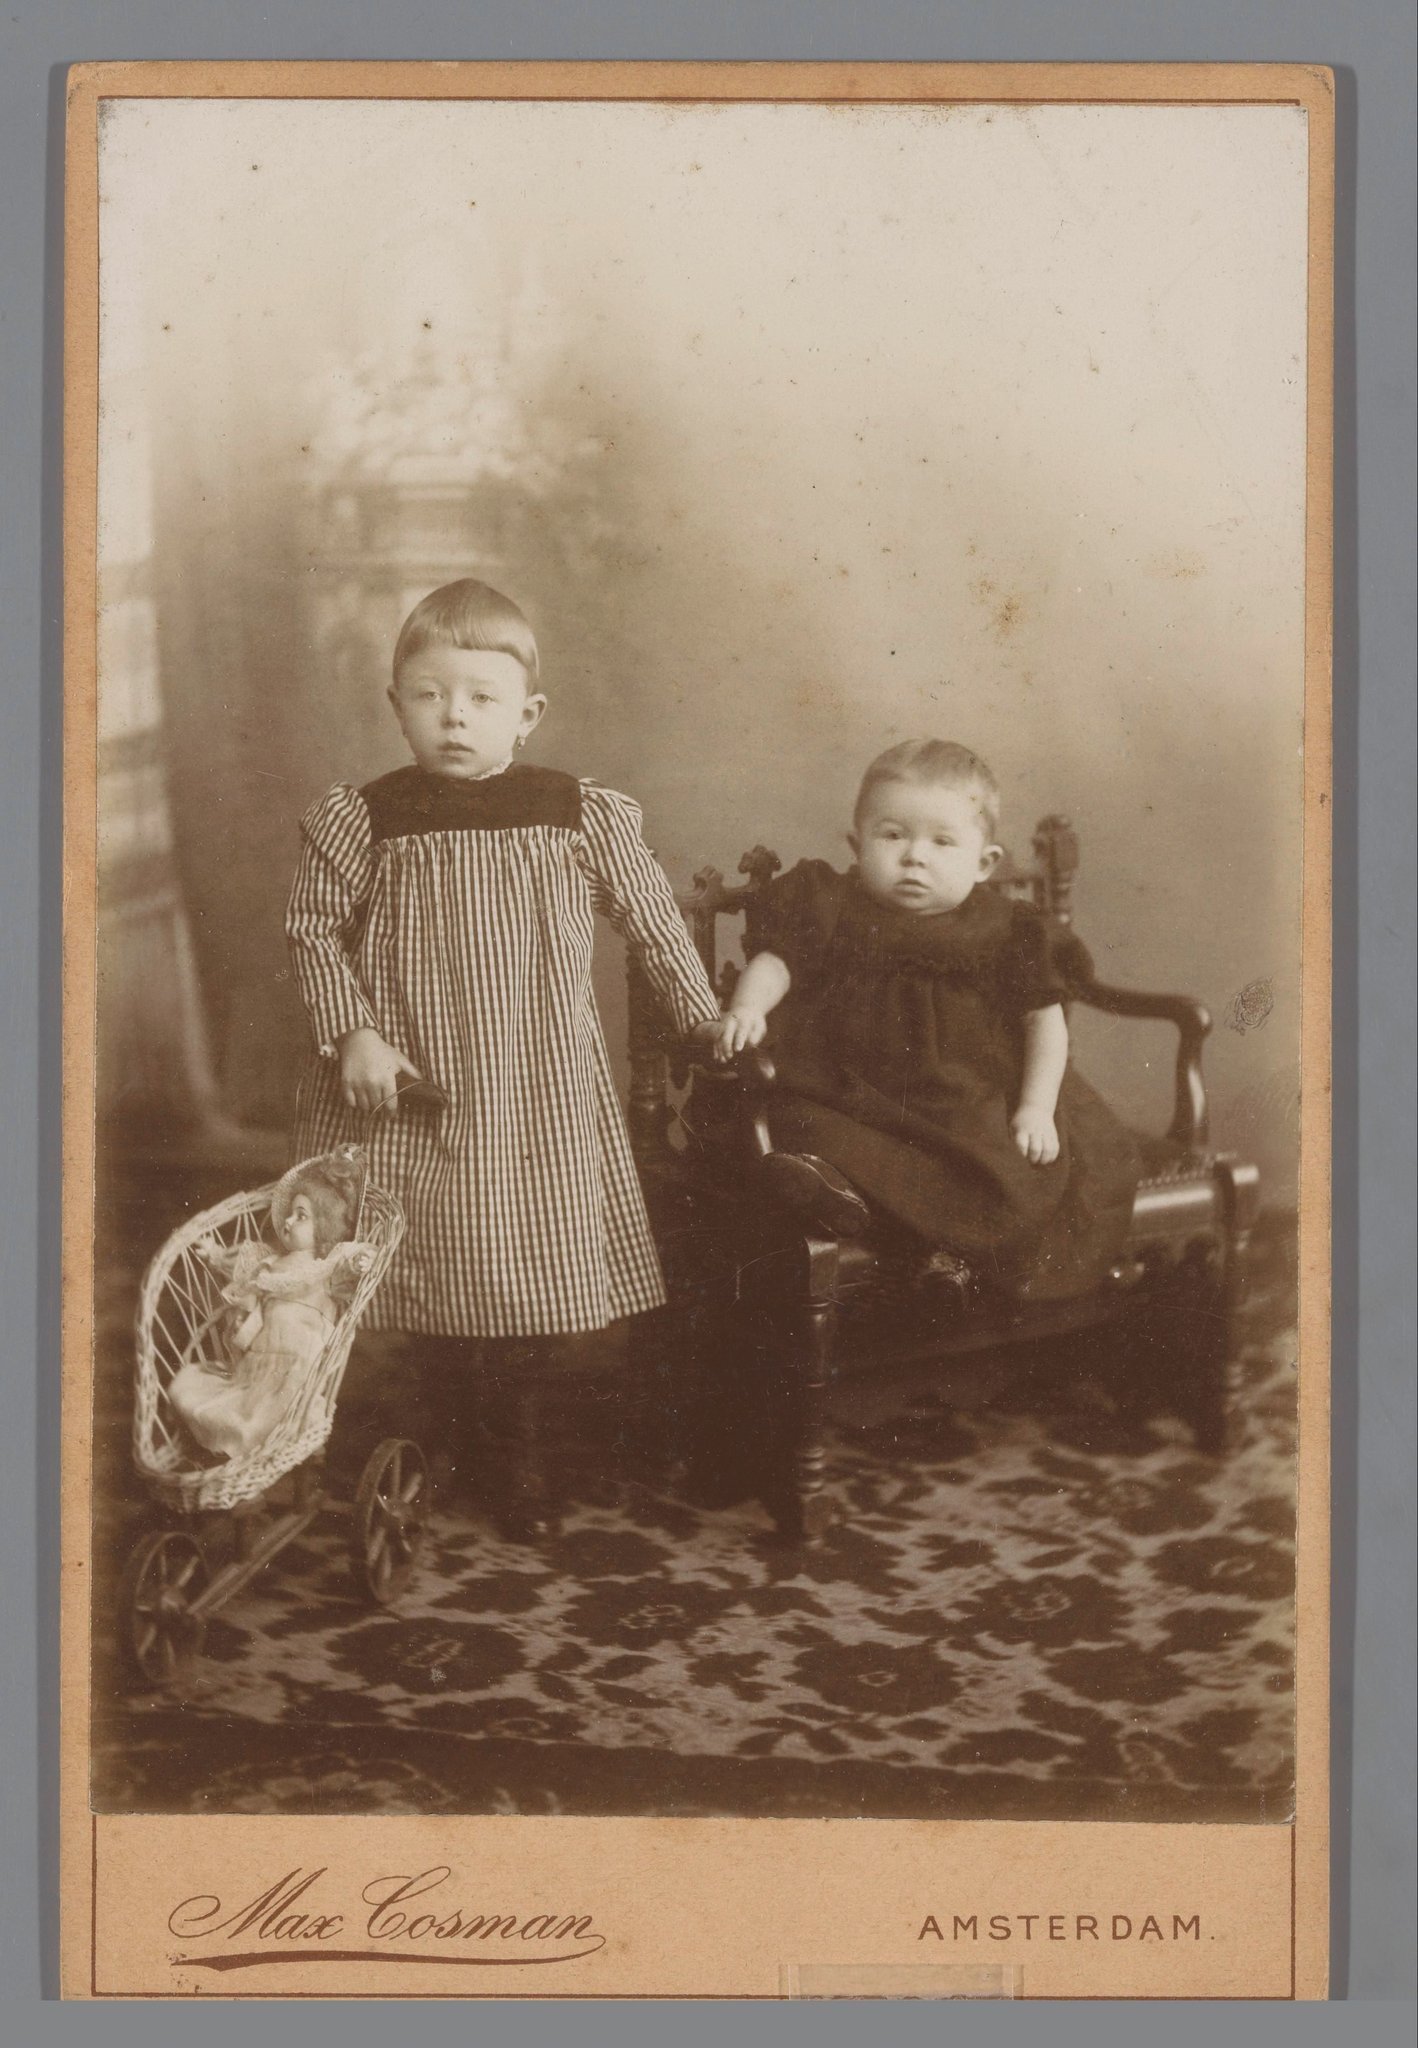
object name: cabinet photograph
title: Portret van twee kinderen met een poppenwagen met pop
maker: max cosman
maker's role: fotograaf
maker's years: 1852-1894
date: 1881-1903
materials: cardboard, photographic support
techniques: collodion silver print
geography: amsterdam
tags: (playing with) dolls, child (at home)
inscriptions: name: ‘Photographisch Atelier Max Cosman Galerij 48 Amsterdam. De plaat blyft voor nabestelling bewaard. Specialiteit in vergrootingen.’